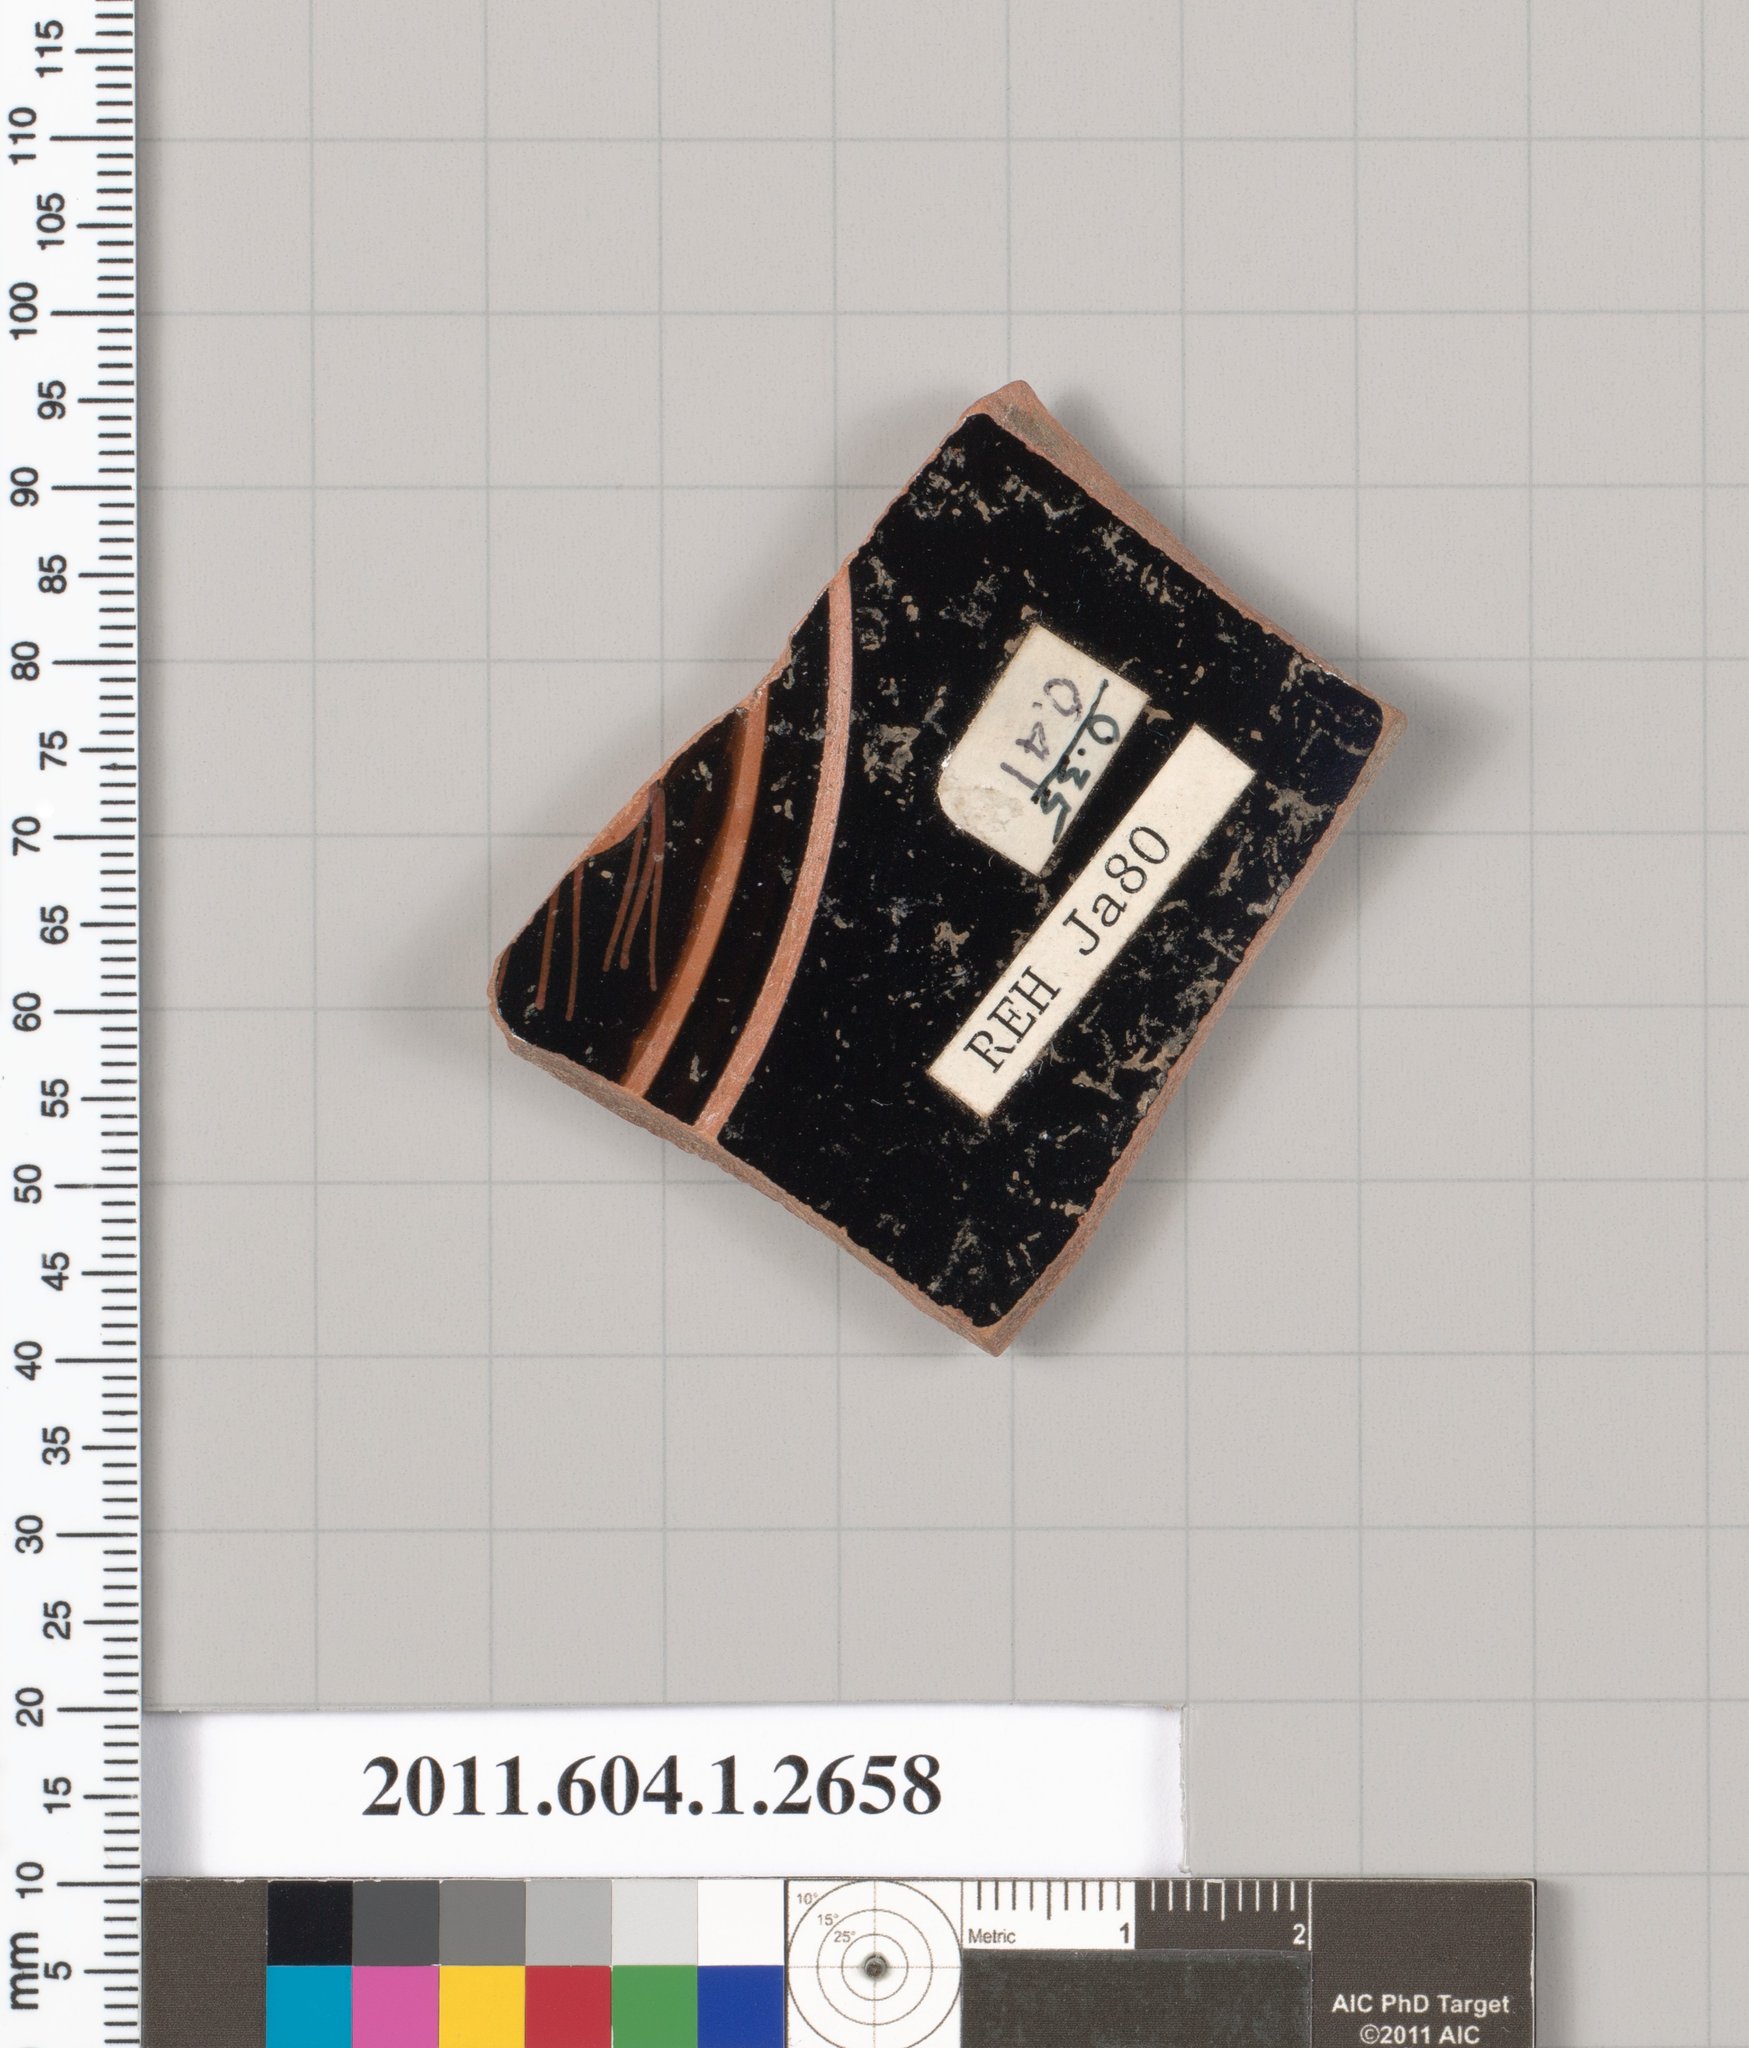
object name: kylix fragment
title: Terracotta fragment of a kylix (drinking cup)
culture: greek, attic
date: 490-480 BCE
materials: terracotta